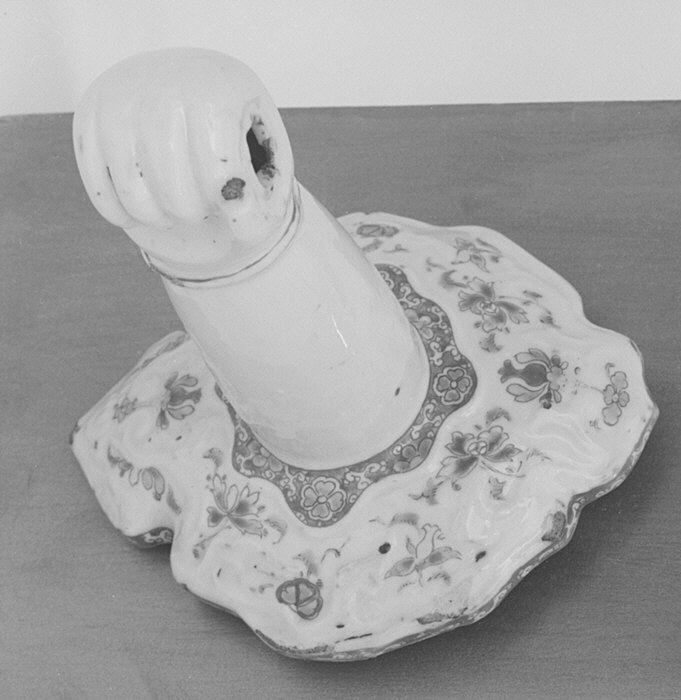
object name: wall bracket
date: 1740-1770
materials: hard paste porcelain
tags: flowers